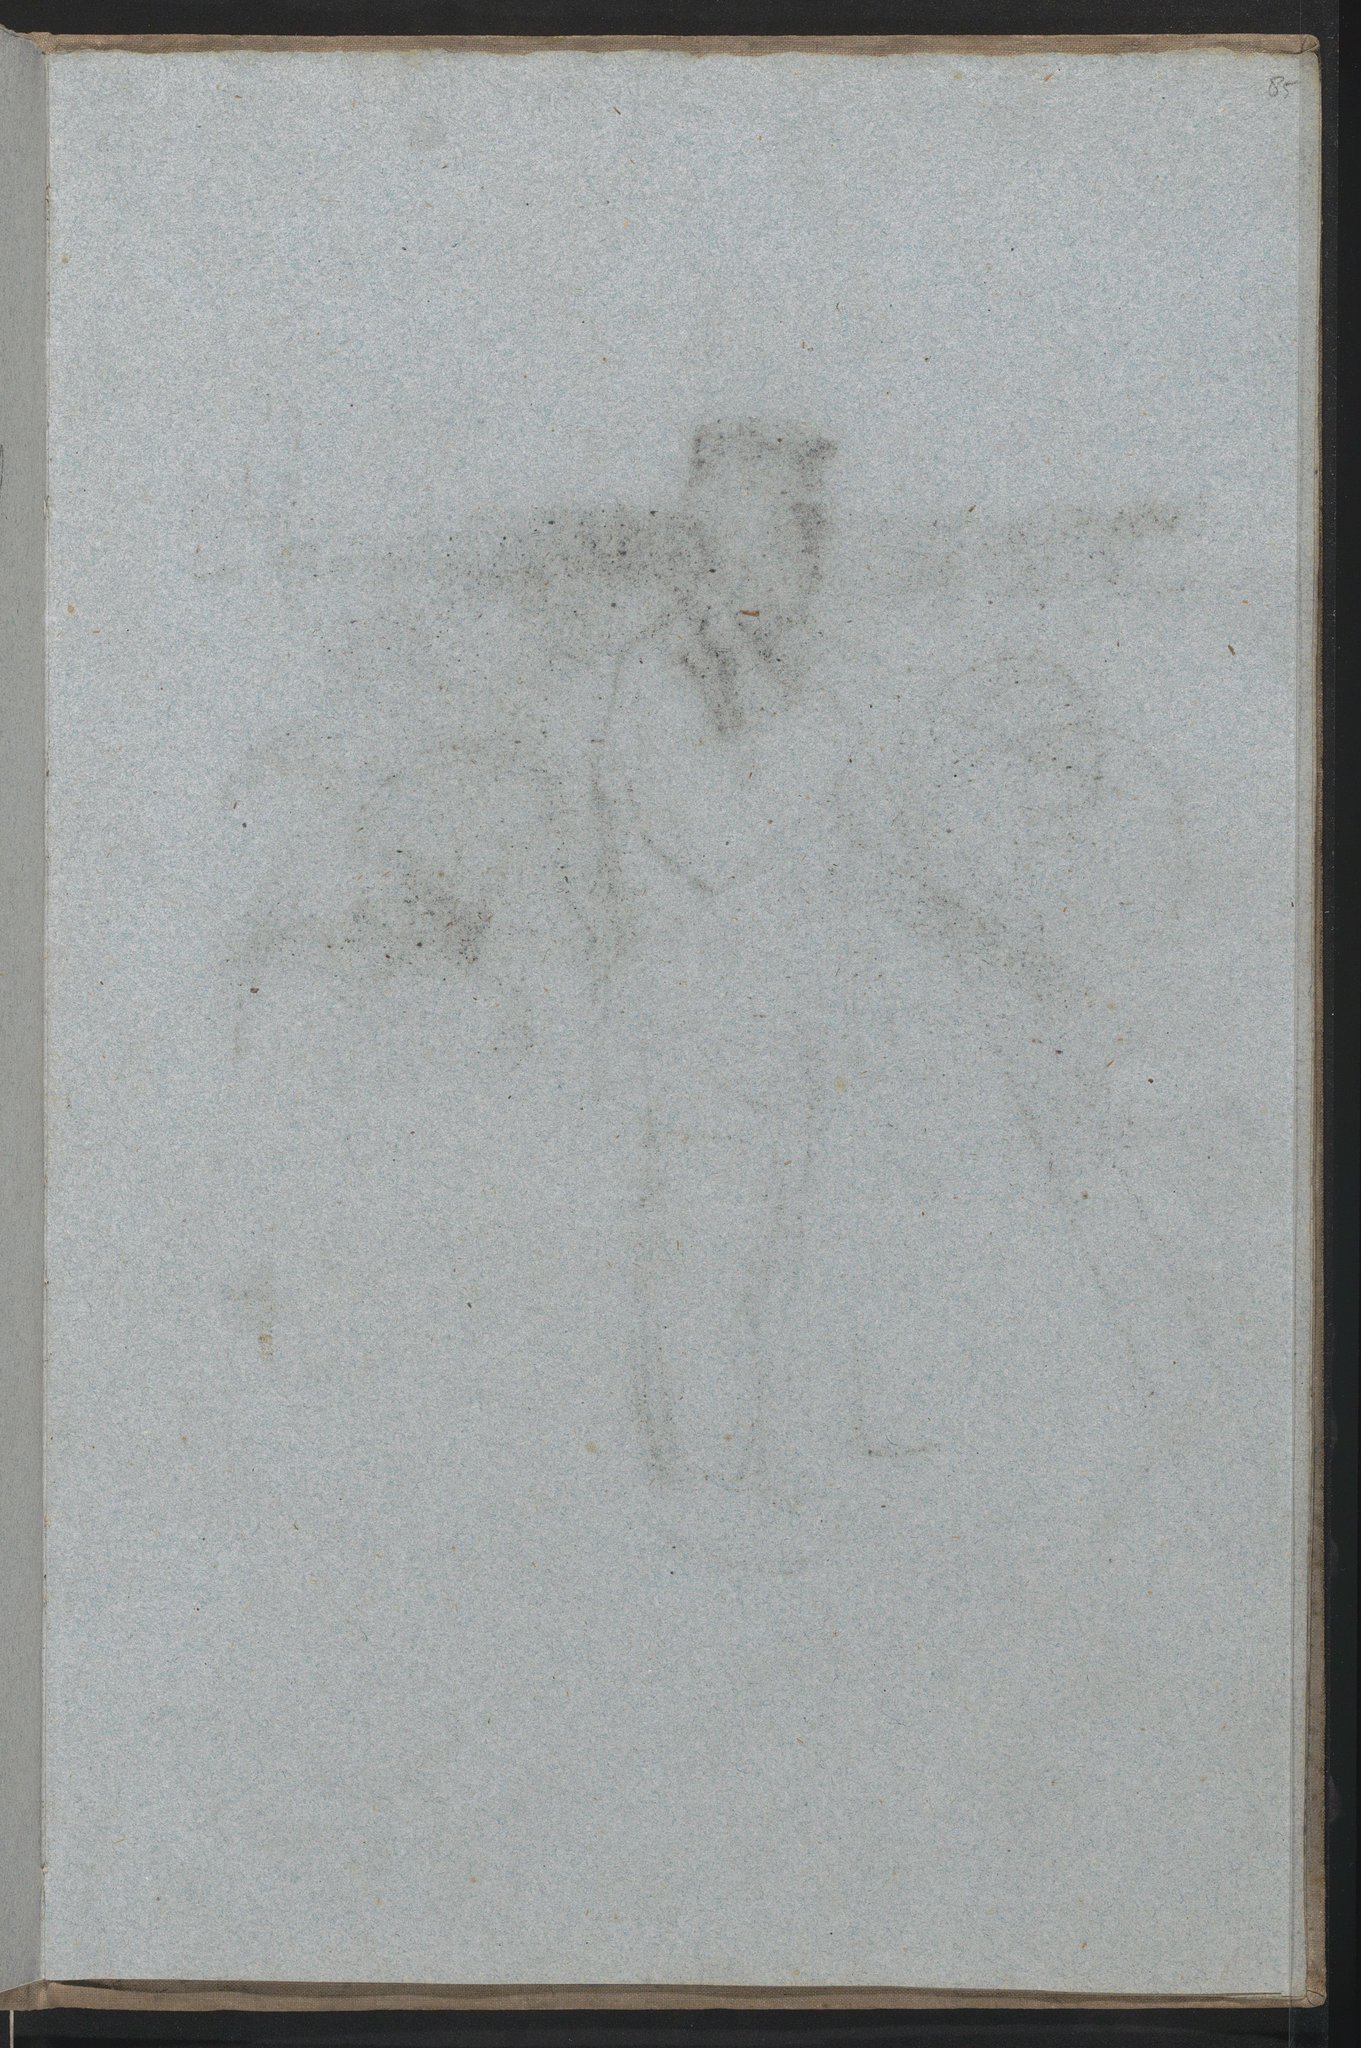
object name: sketchbook leaf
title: Abklatsch van de krijttekening op pagina 84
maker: willem witsen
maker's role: draughtsman, painter, print maker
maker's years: 1860-1923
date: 1884-1887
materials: paper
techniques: printmaking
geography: ewijkshoeve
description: Pagina 85 uit een schetsboek met 45 bladen vervaardigd rond de Ewijkshoeve.